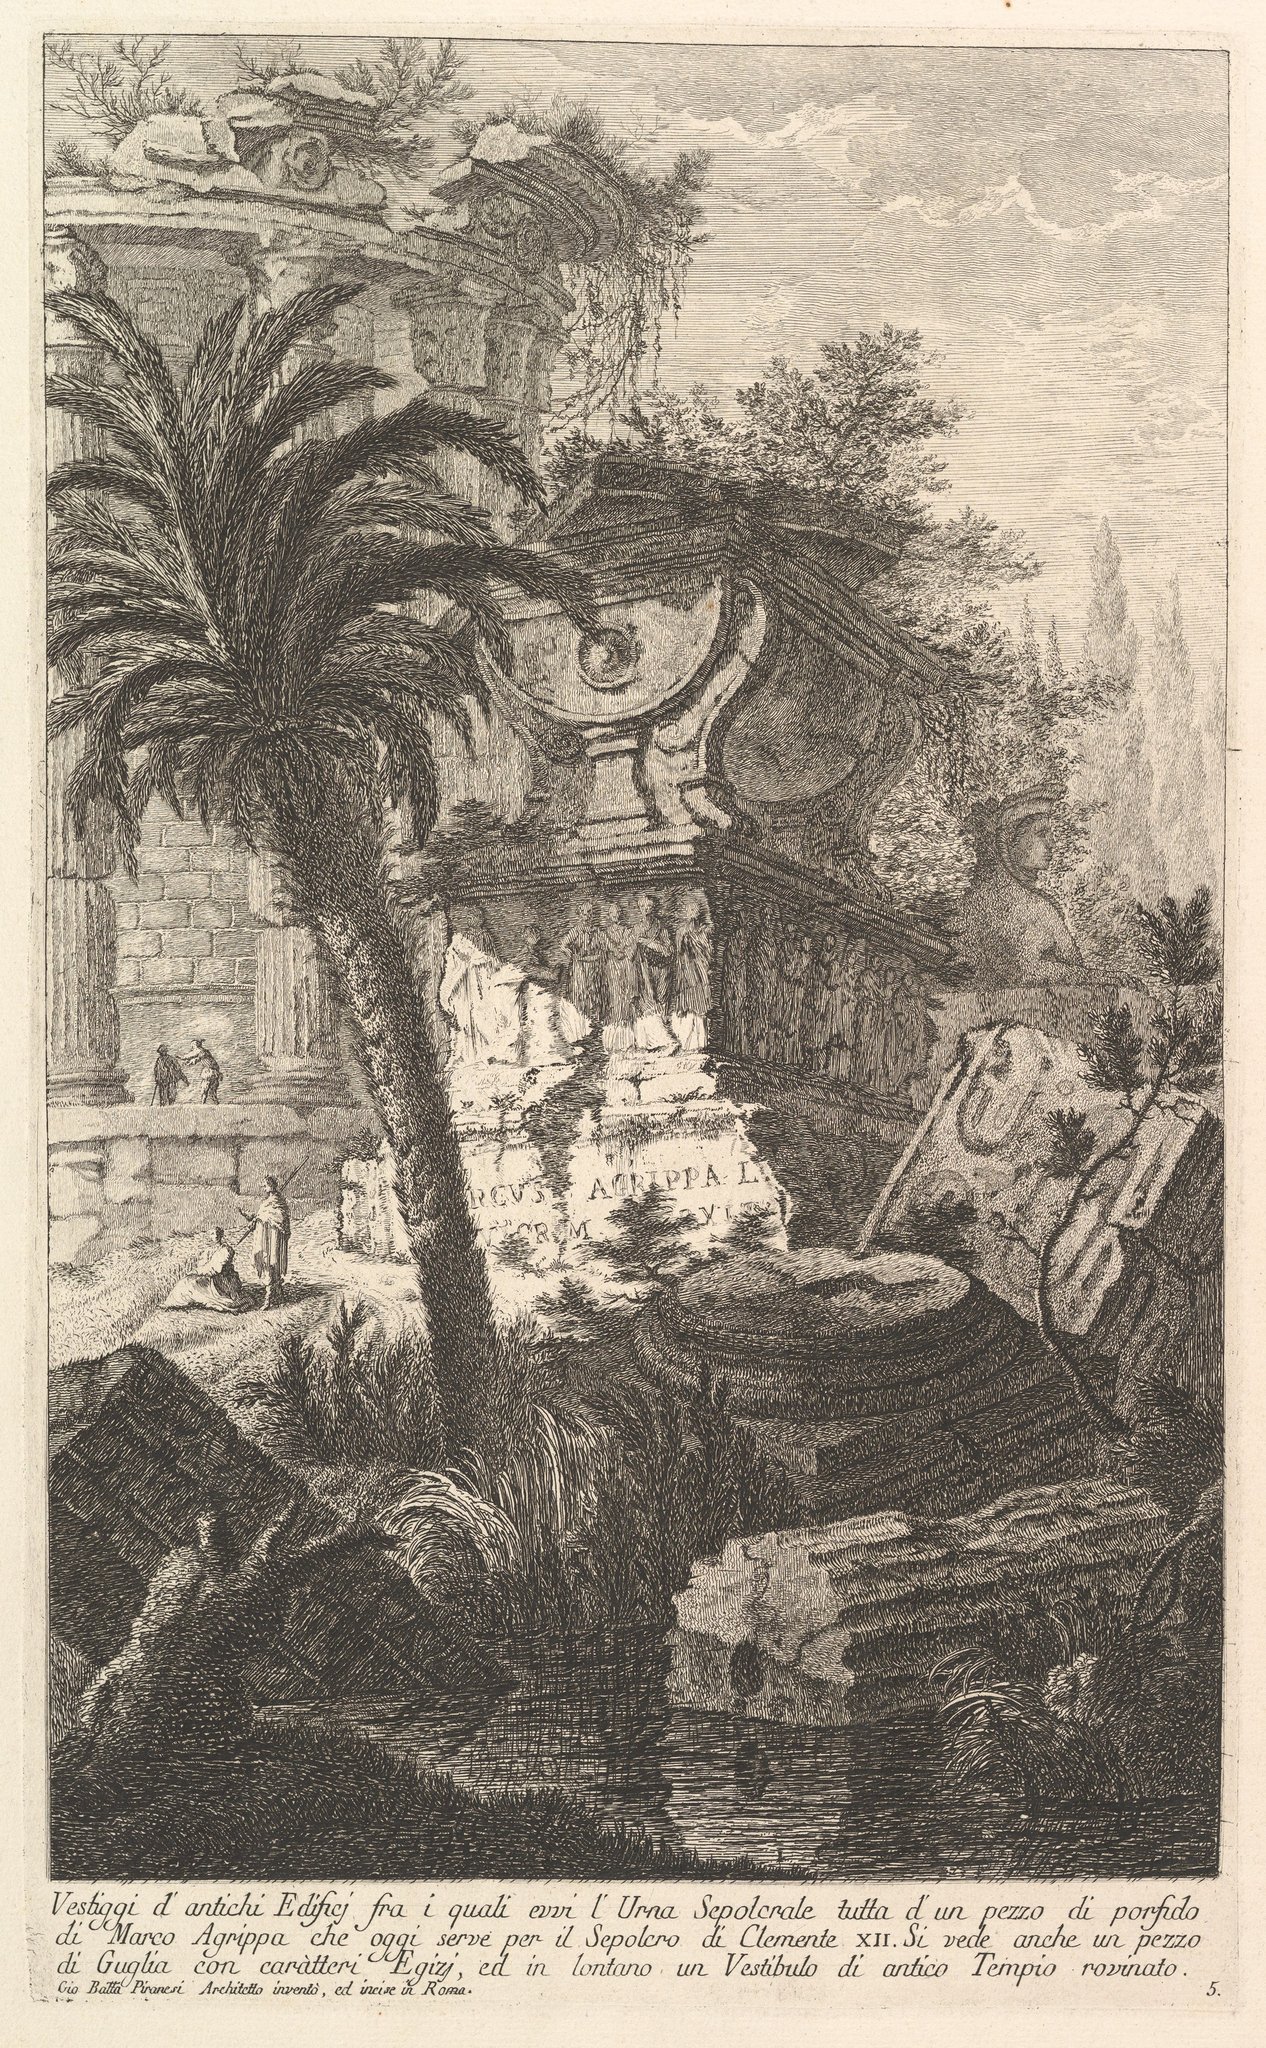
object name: print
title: Remains of ancient buldings among which stands the sepulchral urn of Marcus Agrippa made entirely of porphyry, which serves today as the Tomb of Clement XII... (Vestiggi d'antichi Edifici fra i quali evvi l'Urna Sepolcrale tutta d'un pezzo di...), from "Prima Parte di Architettura, e Prospettive"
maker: giovanni battista piranesi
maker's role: artist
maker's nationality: italian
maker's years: 1720-1778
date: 1750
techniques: etching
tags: ruins,trees